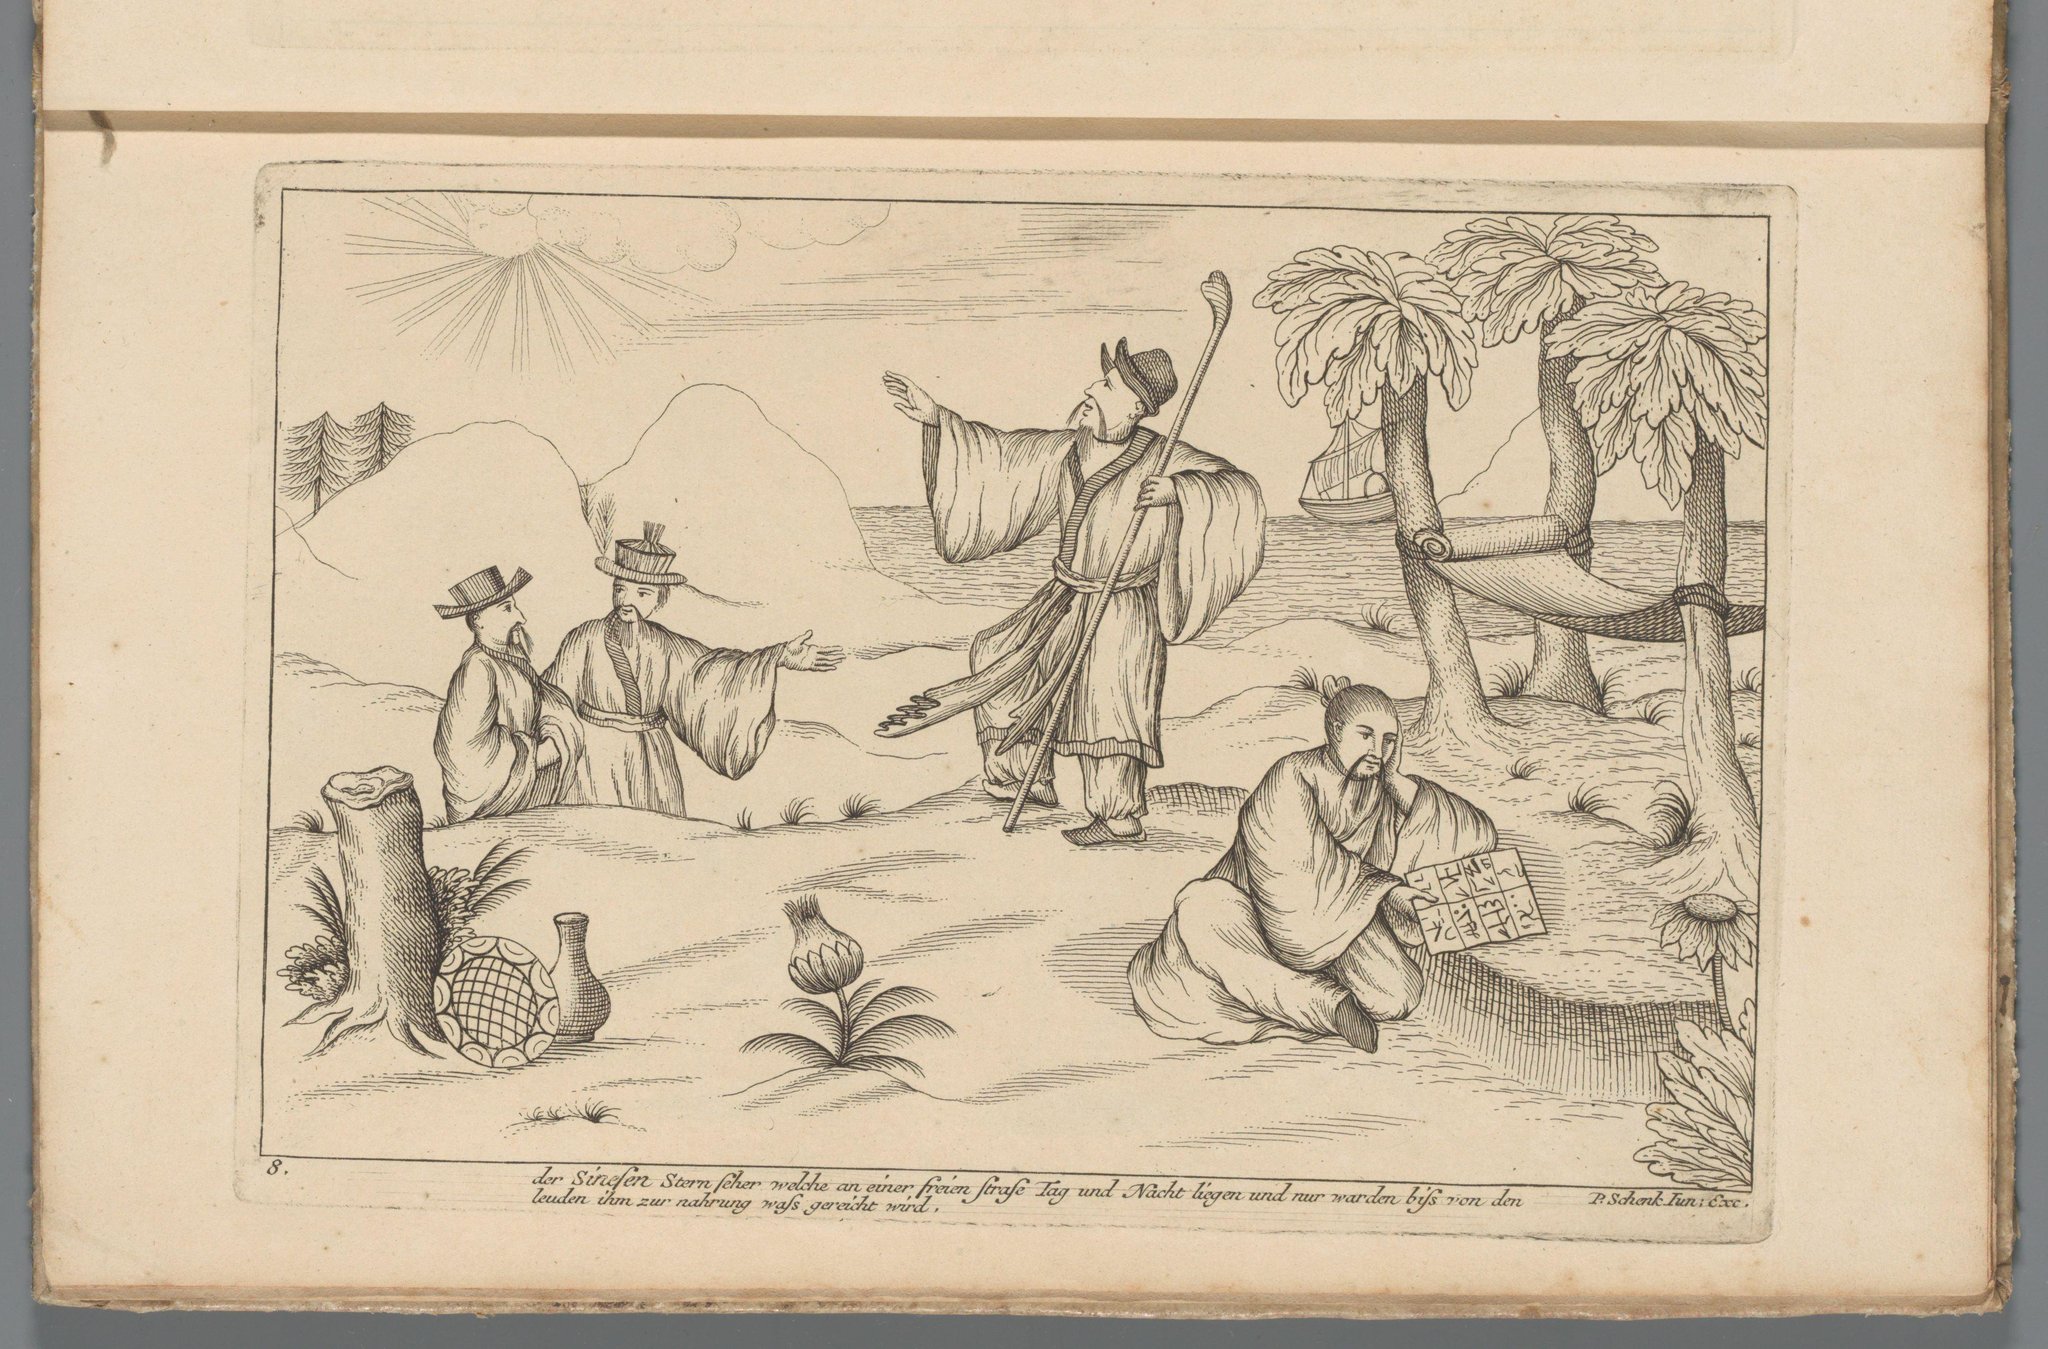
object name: print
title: Chinese sterrenkijkers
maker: pieter schenk (ii)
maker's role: draughtsman, print maker, publisher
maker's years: 1693-1775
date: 1727-1775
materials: paper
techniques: etching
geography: amsterdam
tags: chinese, landscapes in the temperate zone, astrology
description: Chinese sterrenkijkers zitten en staan in een landschap en bestuderen dag en nacht de sterren. Ze leven van wat andere mensen aan eten en drinken brengen. Rechts een hangmat tussen bomen. Prent maakt deel uit van een album.